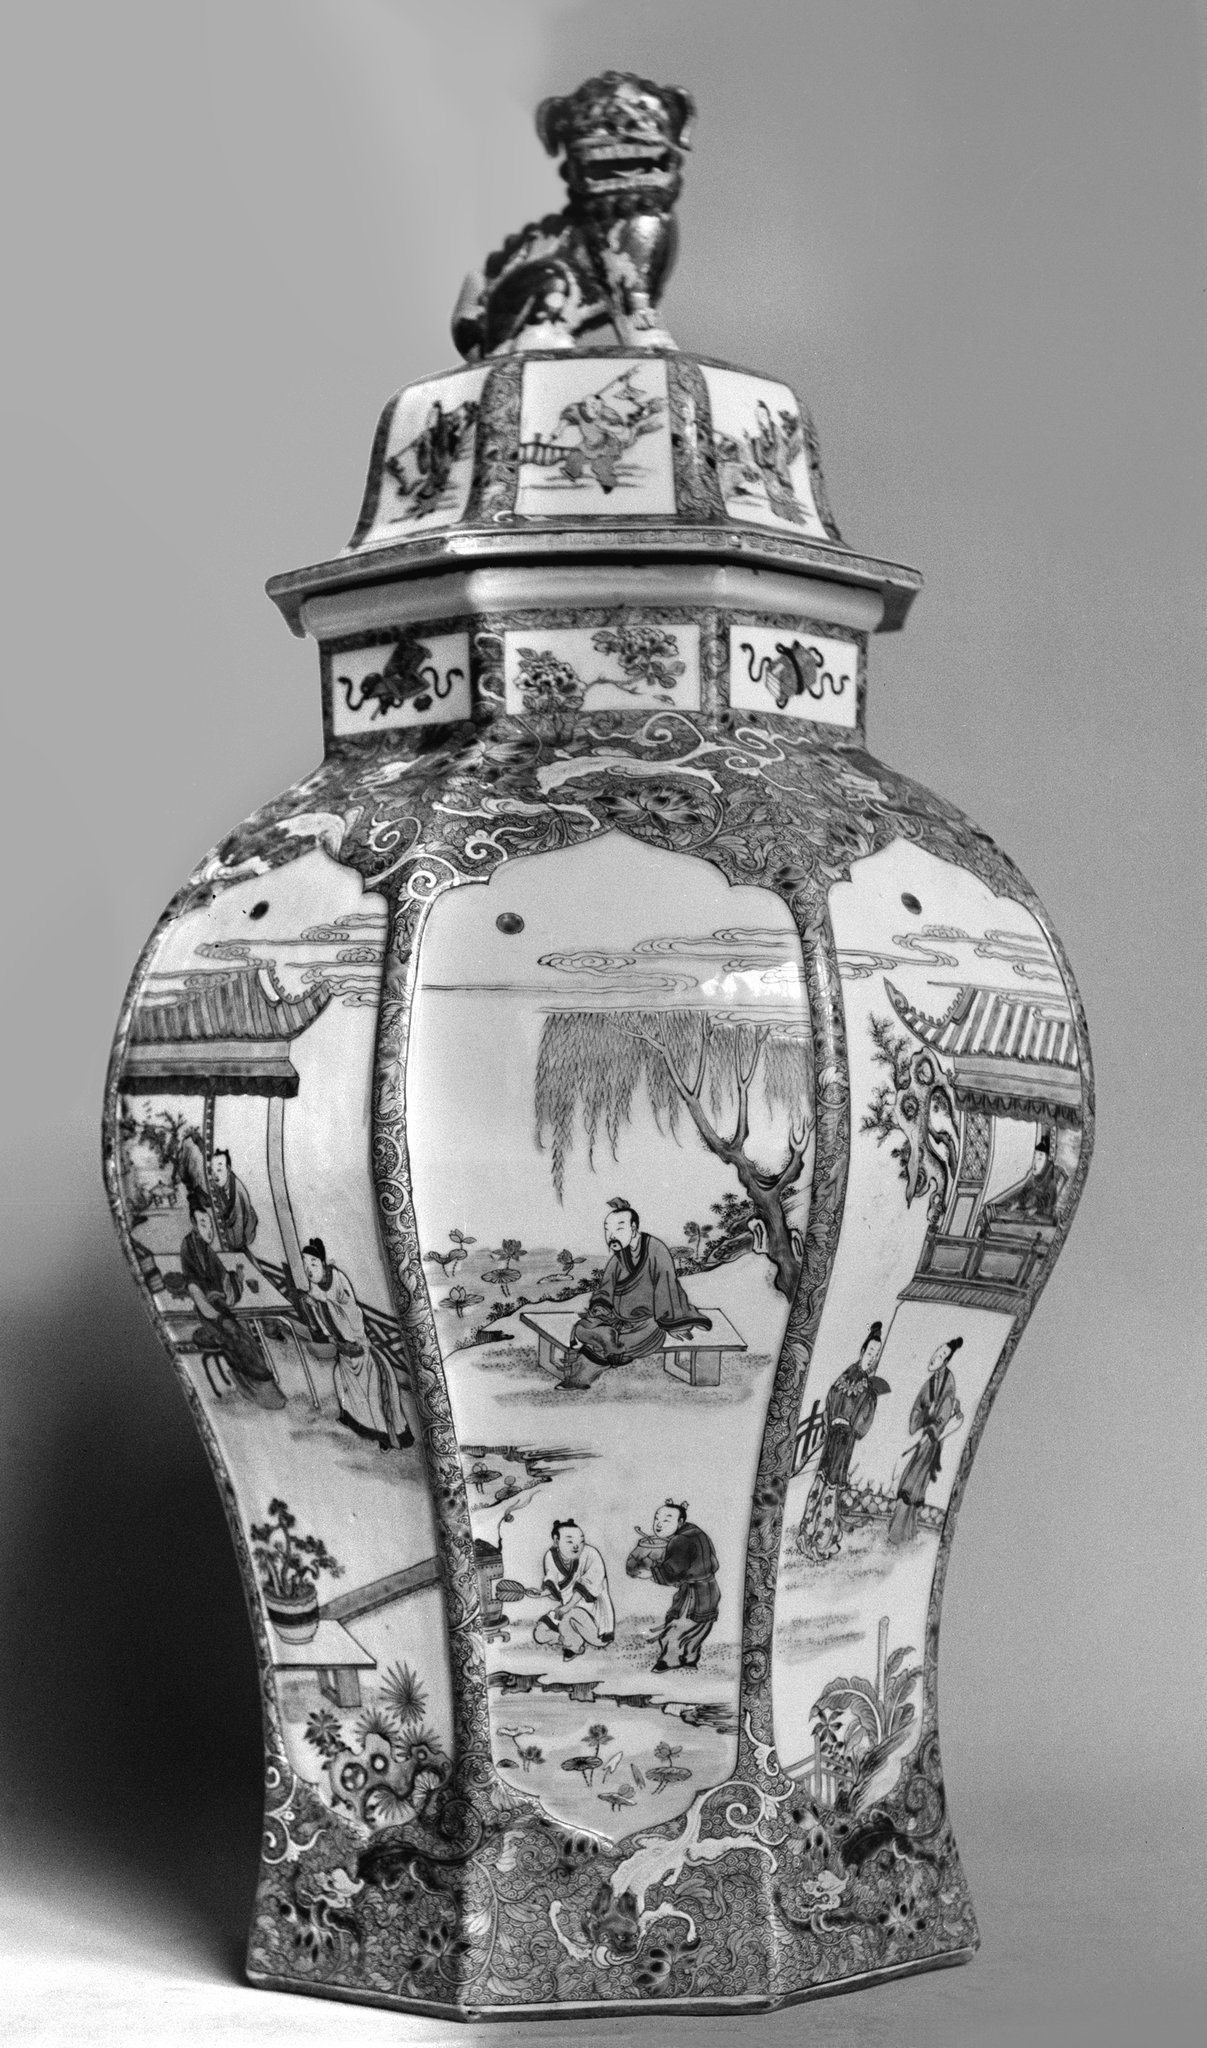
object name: covered jar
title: Covered jar with narrative scenes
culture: chinese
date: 1767-1800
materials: enamel, porcelain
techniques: overglaze, painting, polychrome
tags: animals,men,pavilions